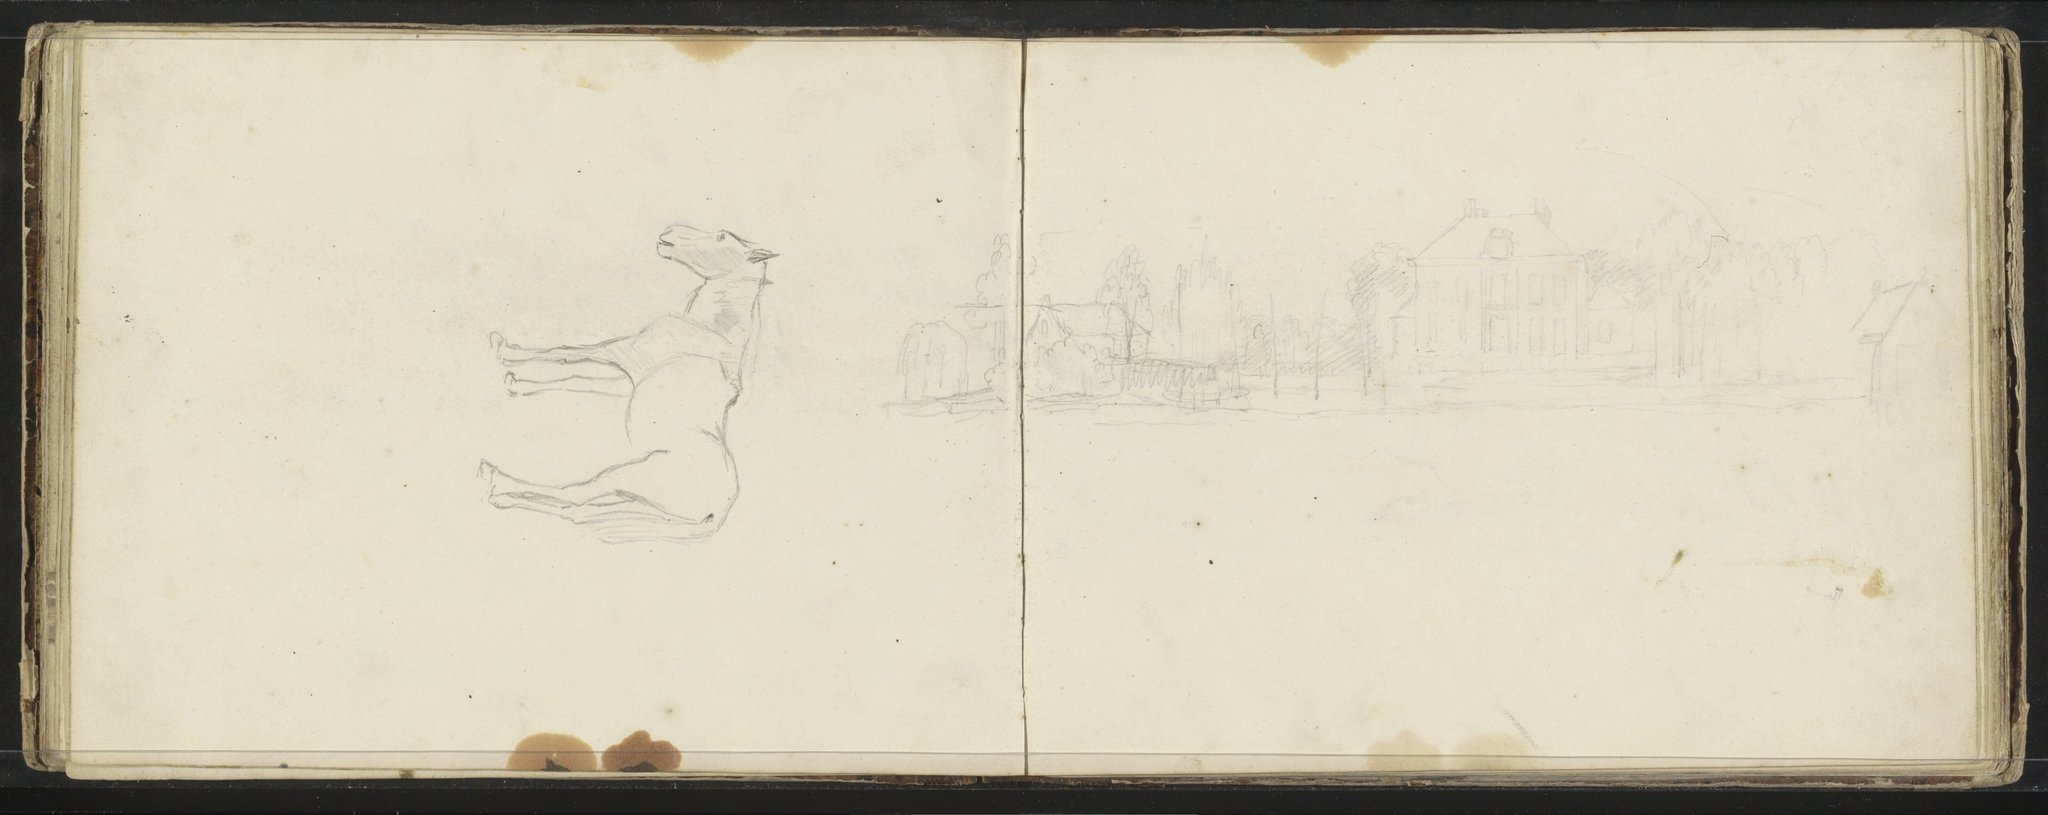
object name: sketchbook leaf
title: Stadsgezicht en een paard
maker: willem troost (ii)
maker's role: draughtsman, painter, print maker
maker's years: 1812-1893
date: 1822-1893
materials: paper, pencil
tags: city-view, and landscape with man-made constructions, horse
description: Blad 30 verso en 31 recto uit een schetsboek met 36 bladen.